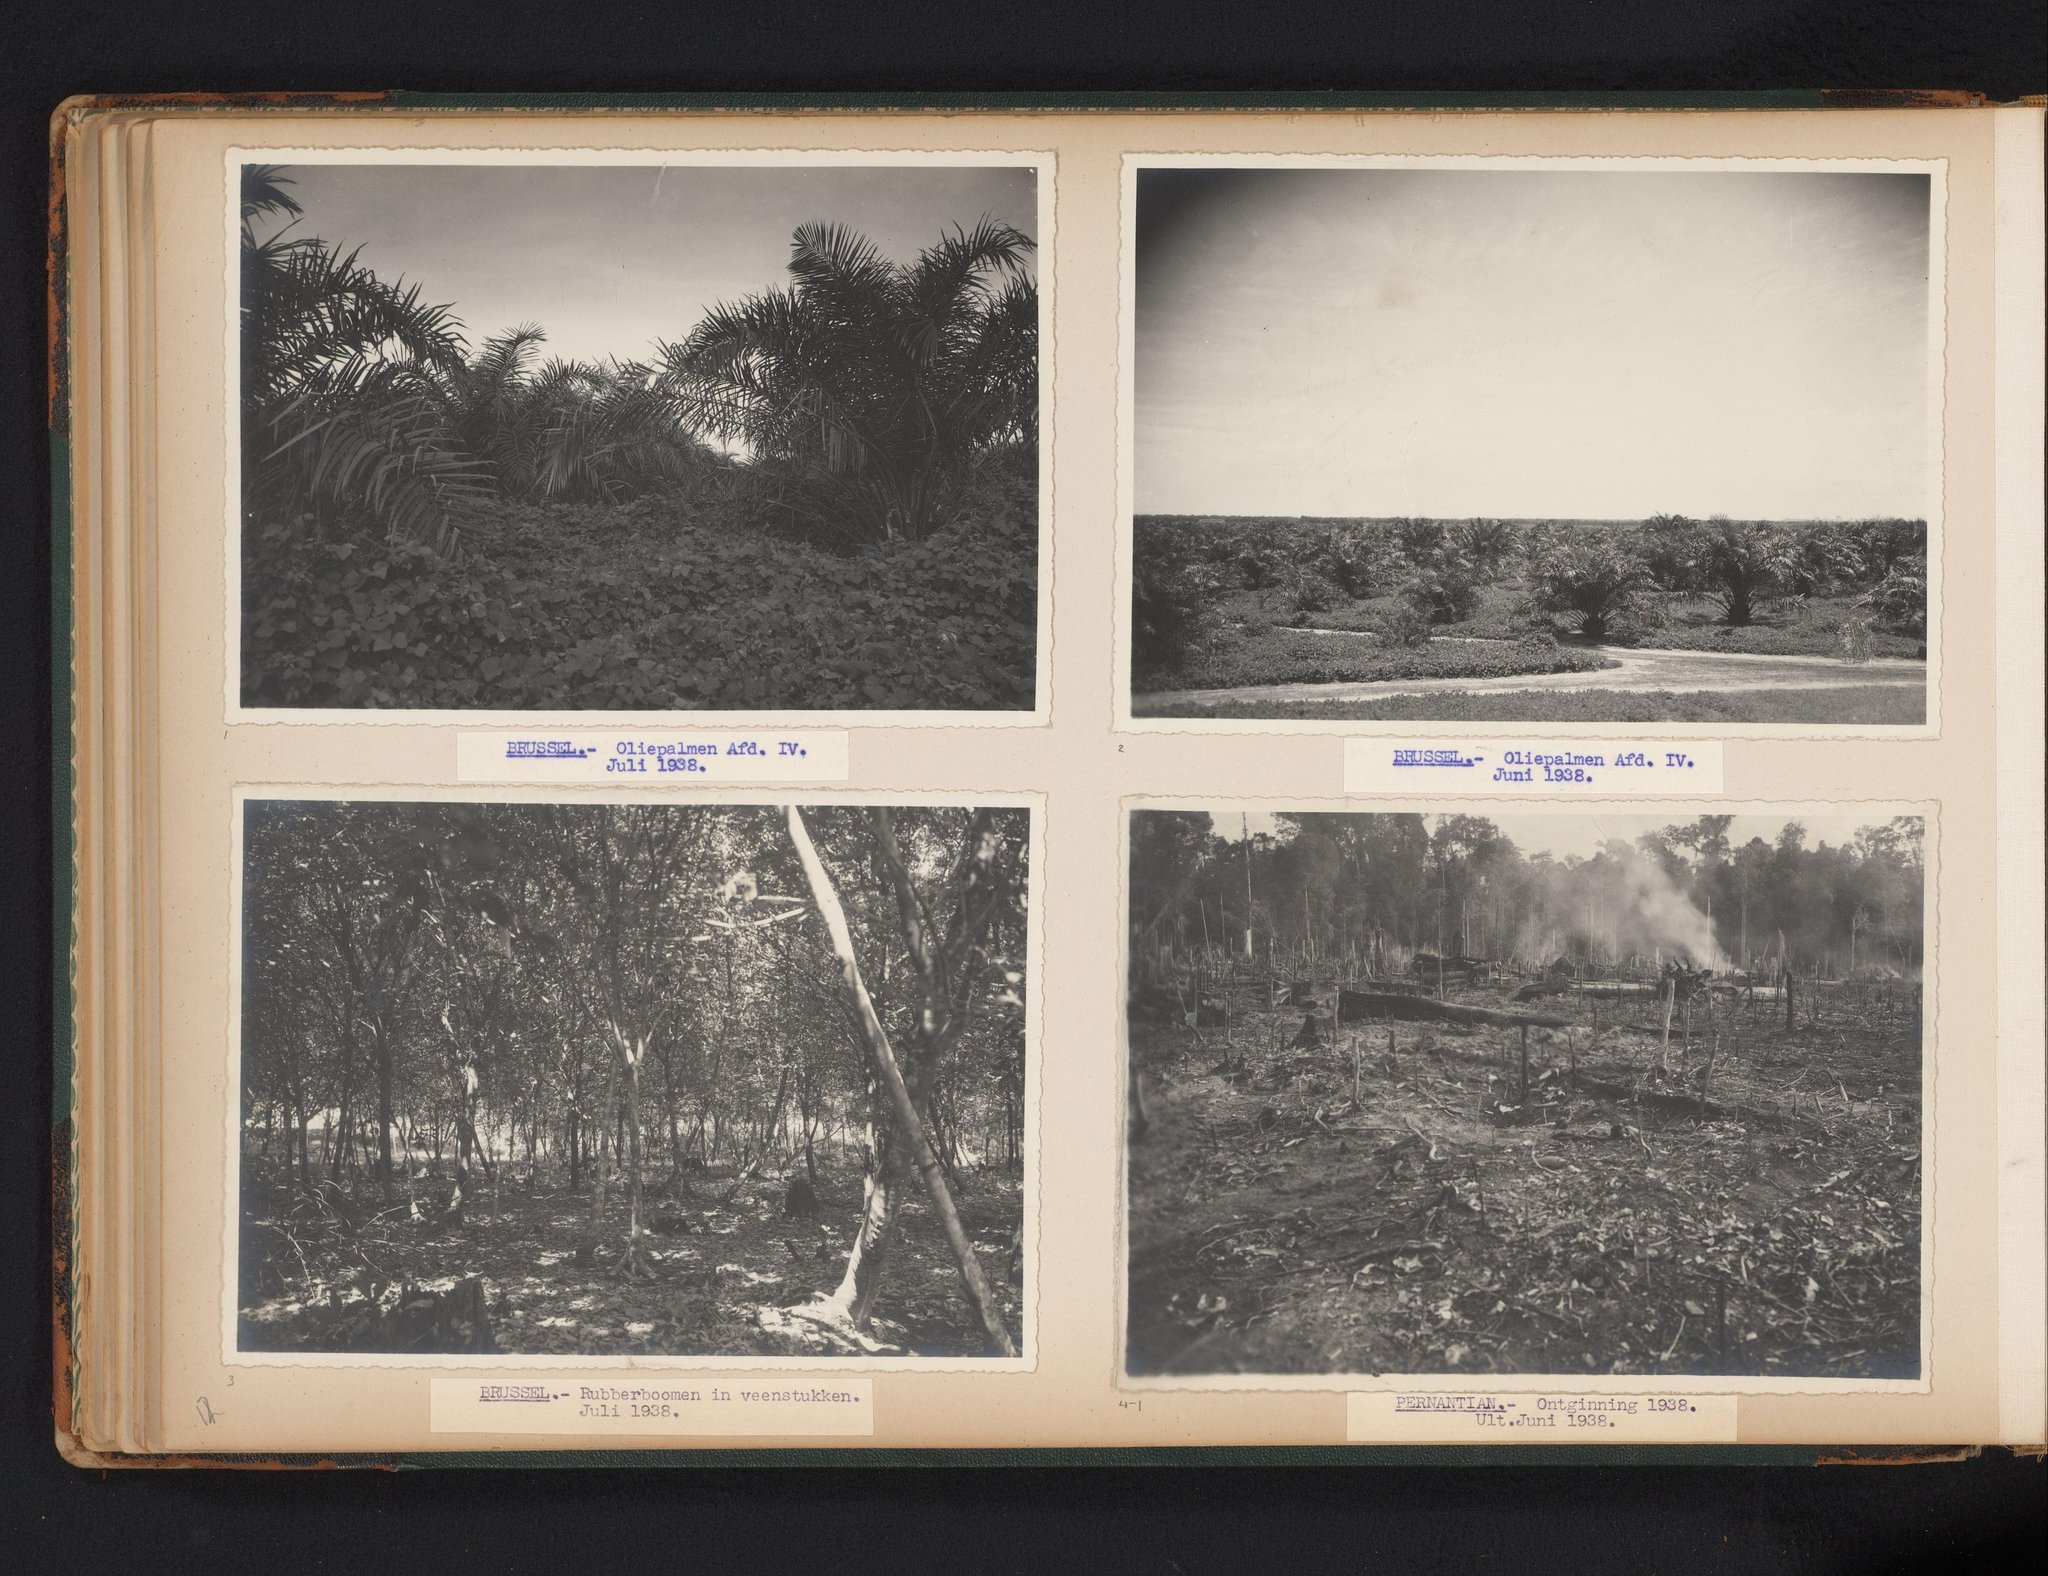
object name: photograph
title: Ontginning op Brussel en Pernantian, 1938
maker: Anonymous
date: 1906-1938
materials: cardboard, photographic support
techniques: gelatin silver print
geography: sumatra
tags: plantation, (non-fruit) products of plants or trees: palm oil, sumatra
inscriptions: inscription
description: Blad met vier foto's van ontginning van nieuwe akkers op Brussel en Pernantian, 1938. Met etiketten met onderschriften onder de foto's. Onderdeel van het fotoalbum over de plantages Pernantian en Brussel van de Sumatra Caoutchouc Maatschappij op de Oostkust van Sumatra in de jaren 1935-1939.